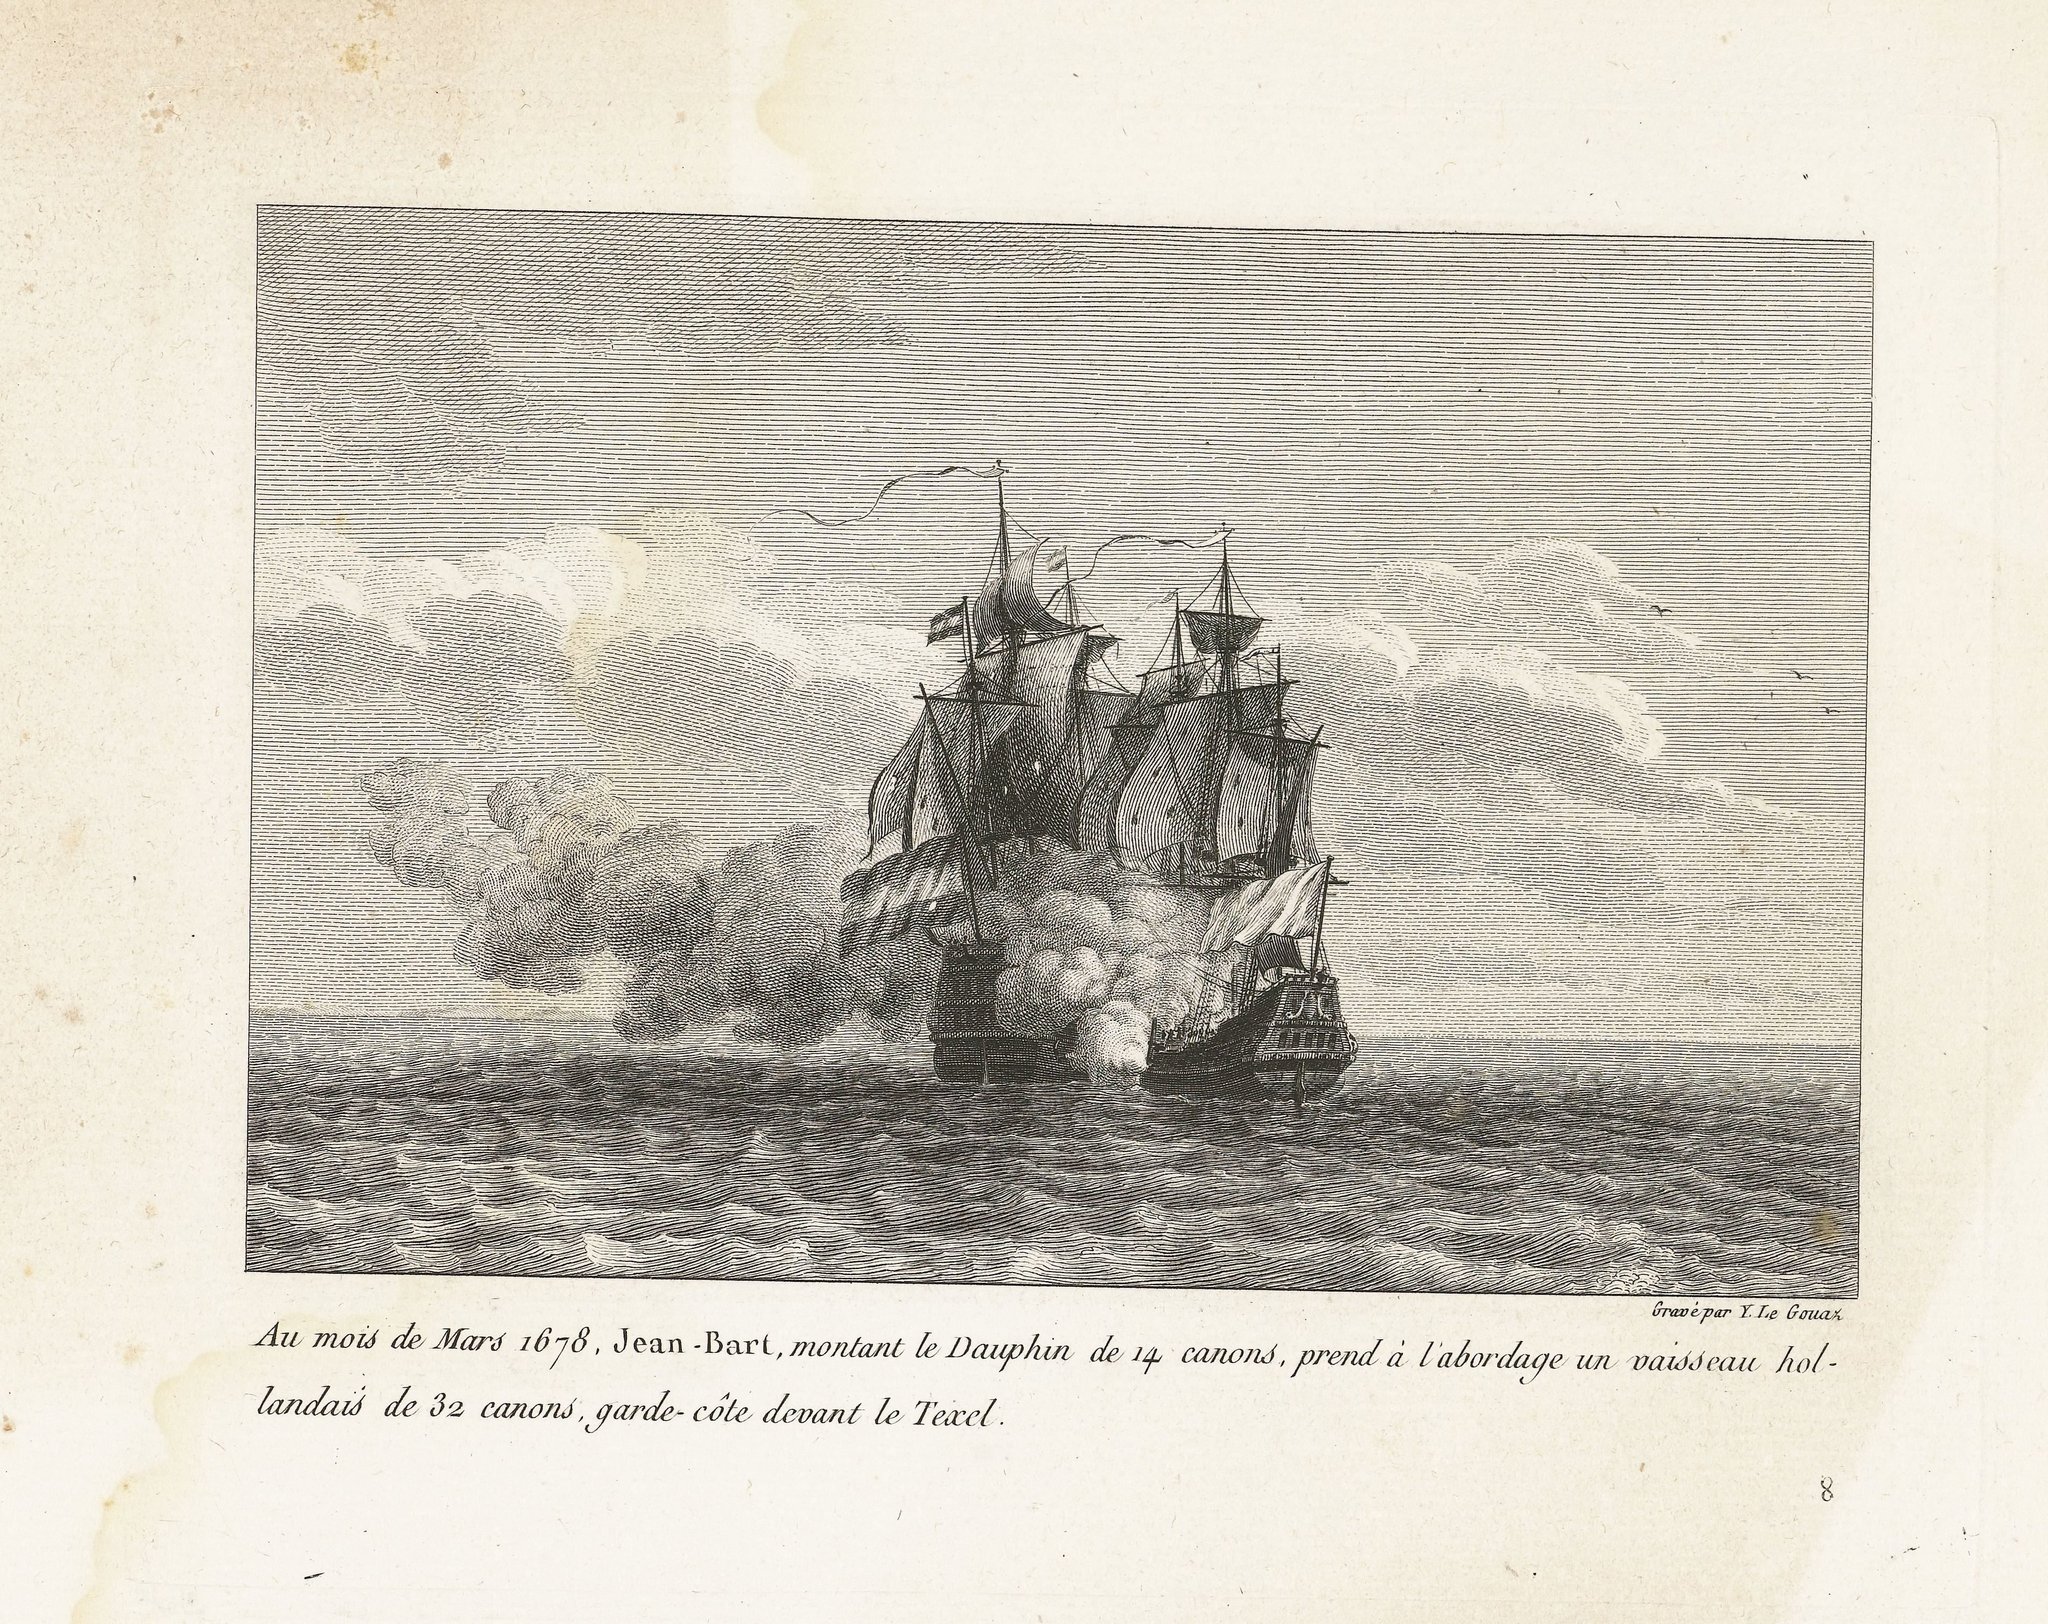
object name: history print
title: Au mois de Mars 1678, Jean-Bart, montant le Dauphin de 14 canons, prend à l'abordage un vaisseau hollandais de 32 canons, garde-côte devant le Texel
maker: yves marie le gouaz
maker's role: print maker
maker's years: 1742-1816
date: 1806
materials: paper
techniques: etching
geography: paris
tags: battle (+ naval force)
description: Jan Bart verovert een Hollands fregat bij Texel, maart 1678. Onderdeel van een serie over de daden van de Vlaamse kaper in Franse dienst Jan Bart.